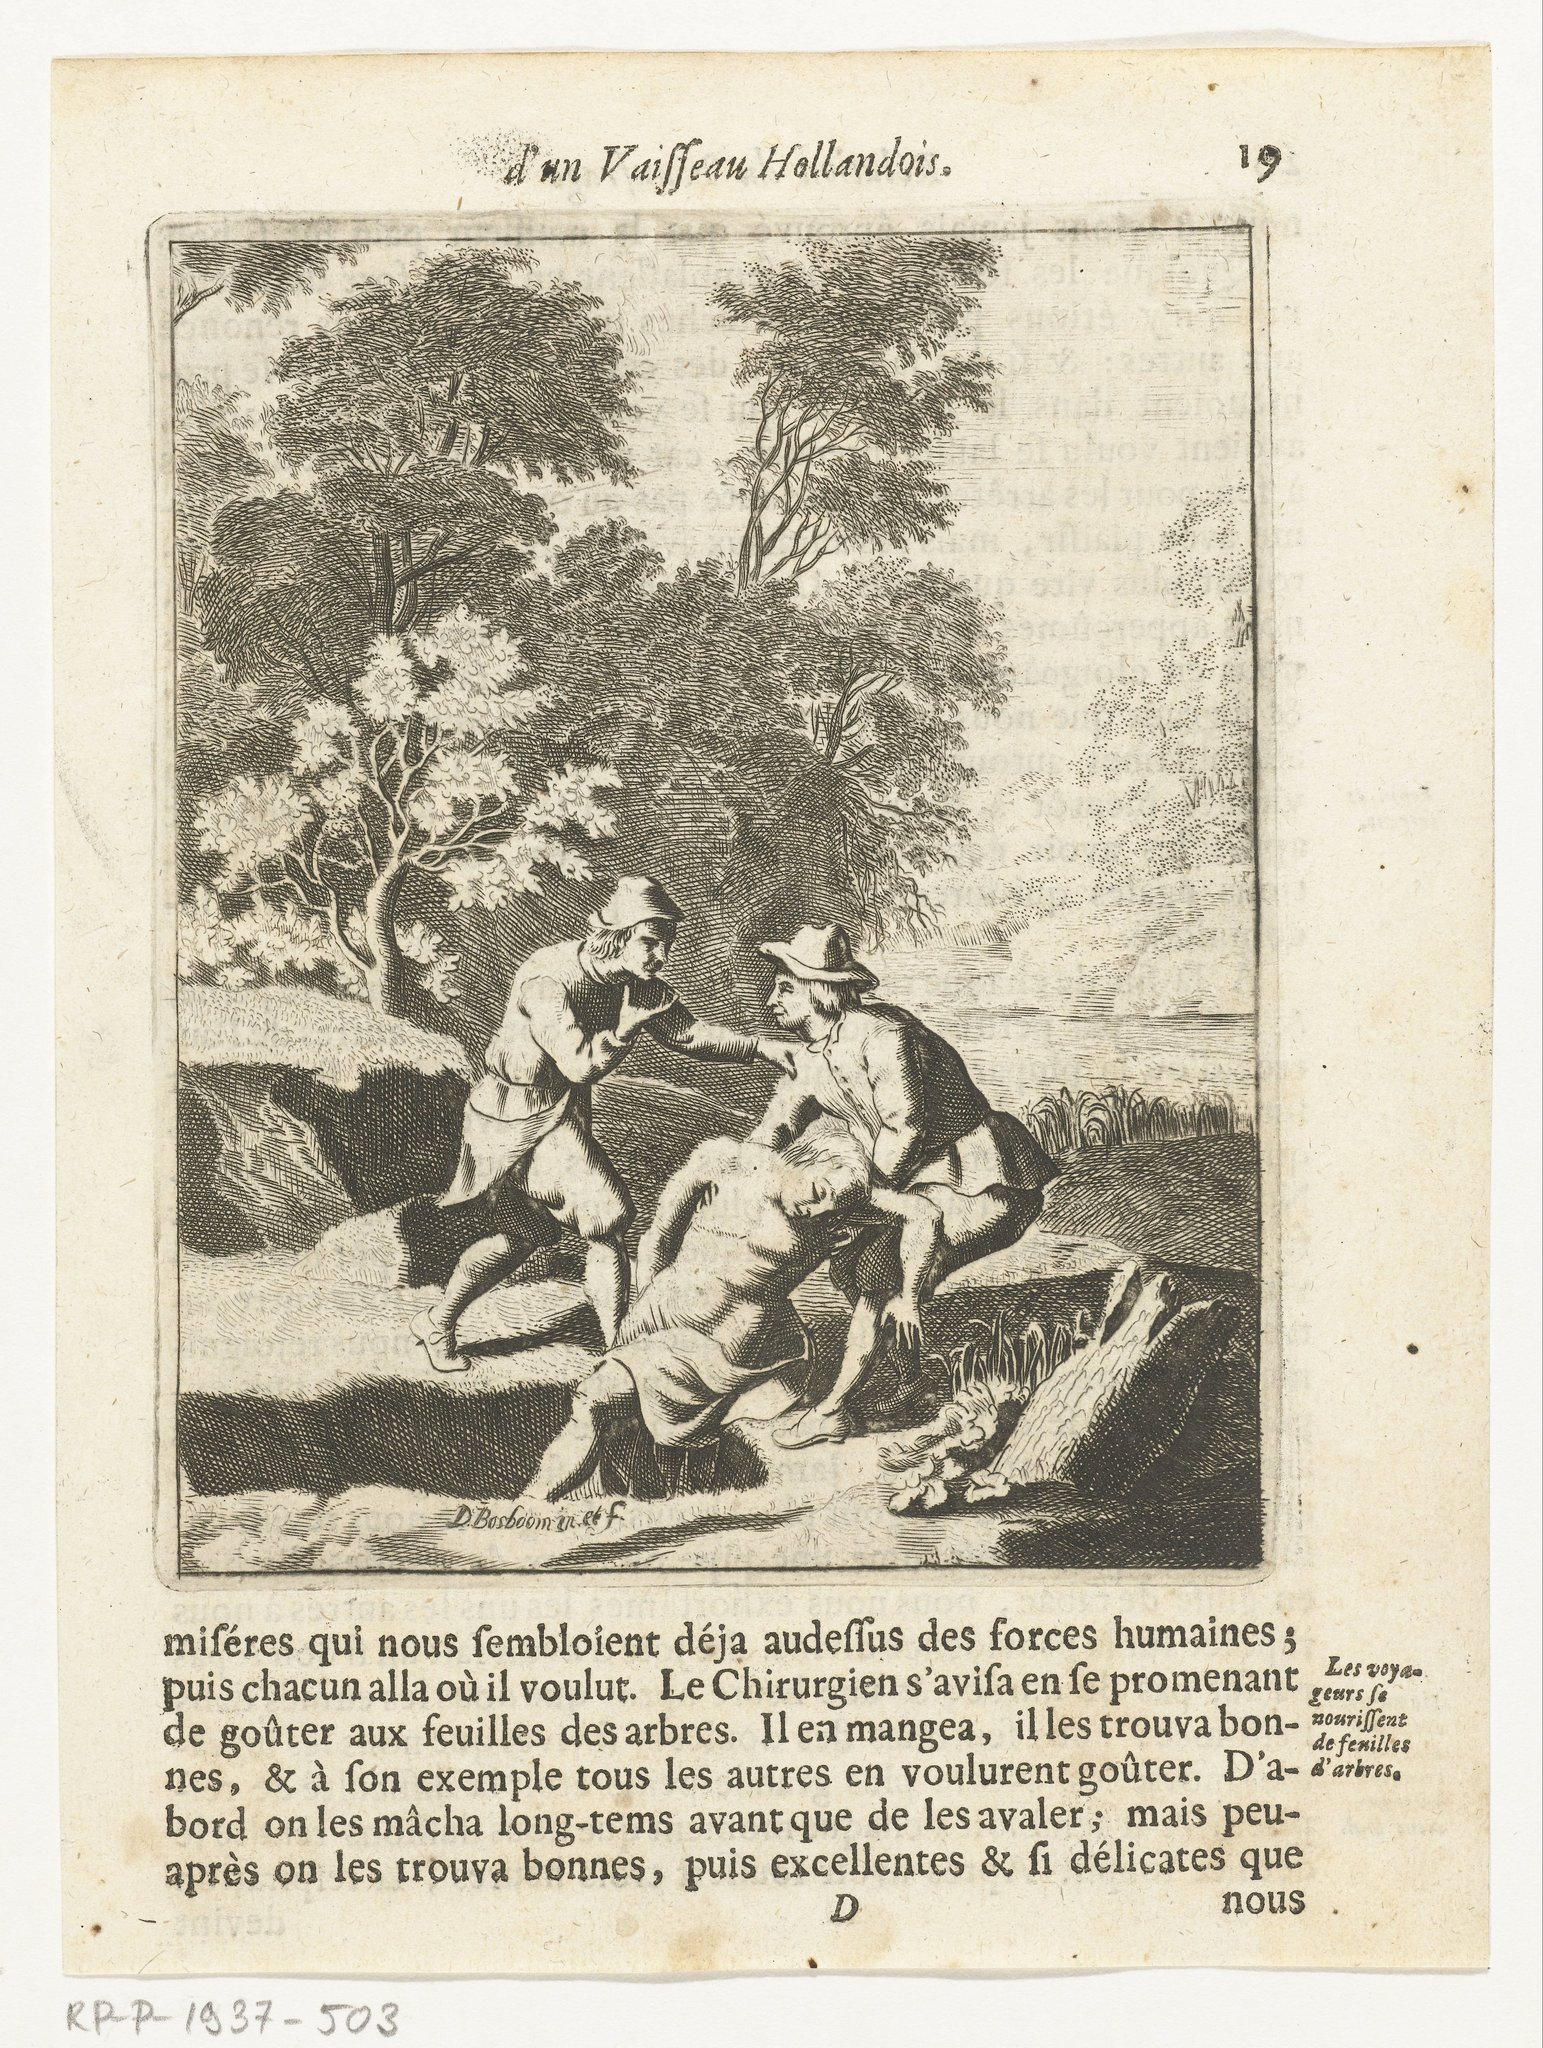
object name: print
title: Twee mannen halen een dode uit een graf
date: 1681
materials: paper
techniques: engraving, etching, letterpress printing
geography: amsterdam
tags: discovery of tomb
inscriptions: collector's mark: Lugt 2760, collector's mark: Lugt 2228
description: Twee bemanningsleden van de Terschelling openen een graf en halen de dode eruit. Ze twisten erover of ze het vlees zouden eten of niet. Uiteindelijk beslissen ze de dode weer in het graf te leggen en het lichaam onaangeraakt te laten. Bladzijde uit een boek, met illustratie en tekst op het recto en verso.